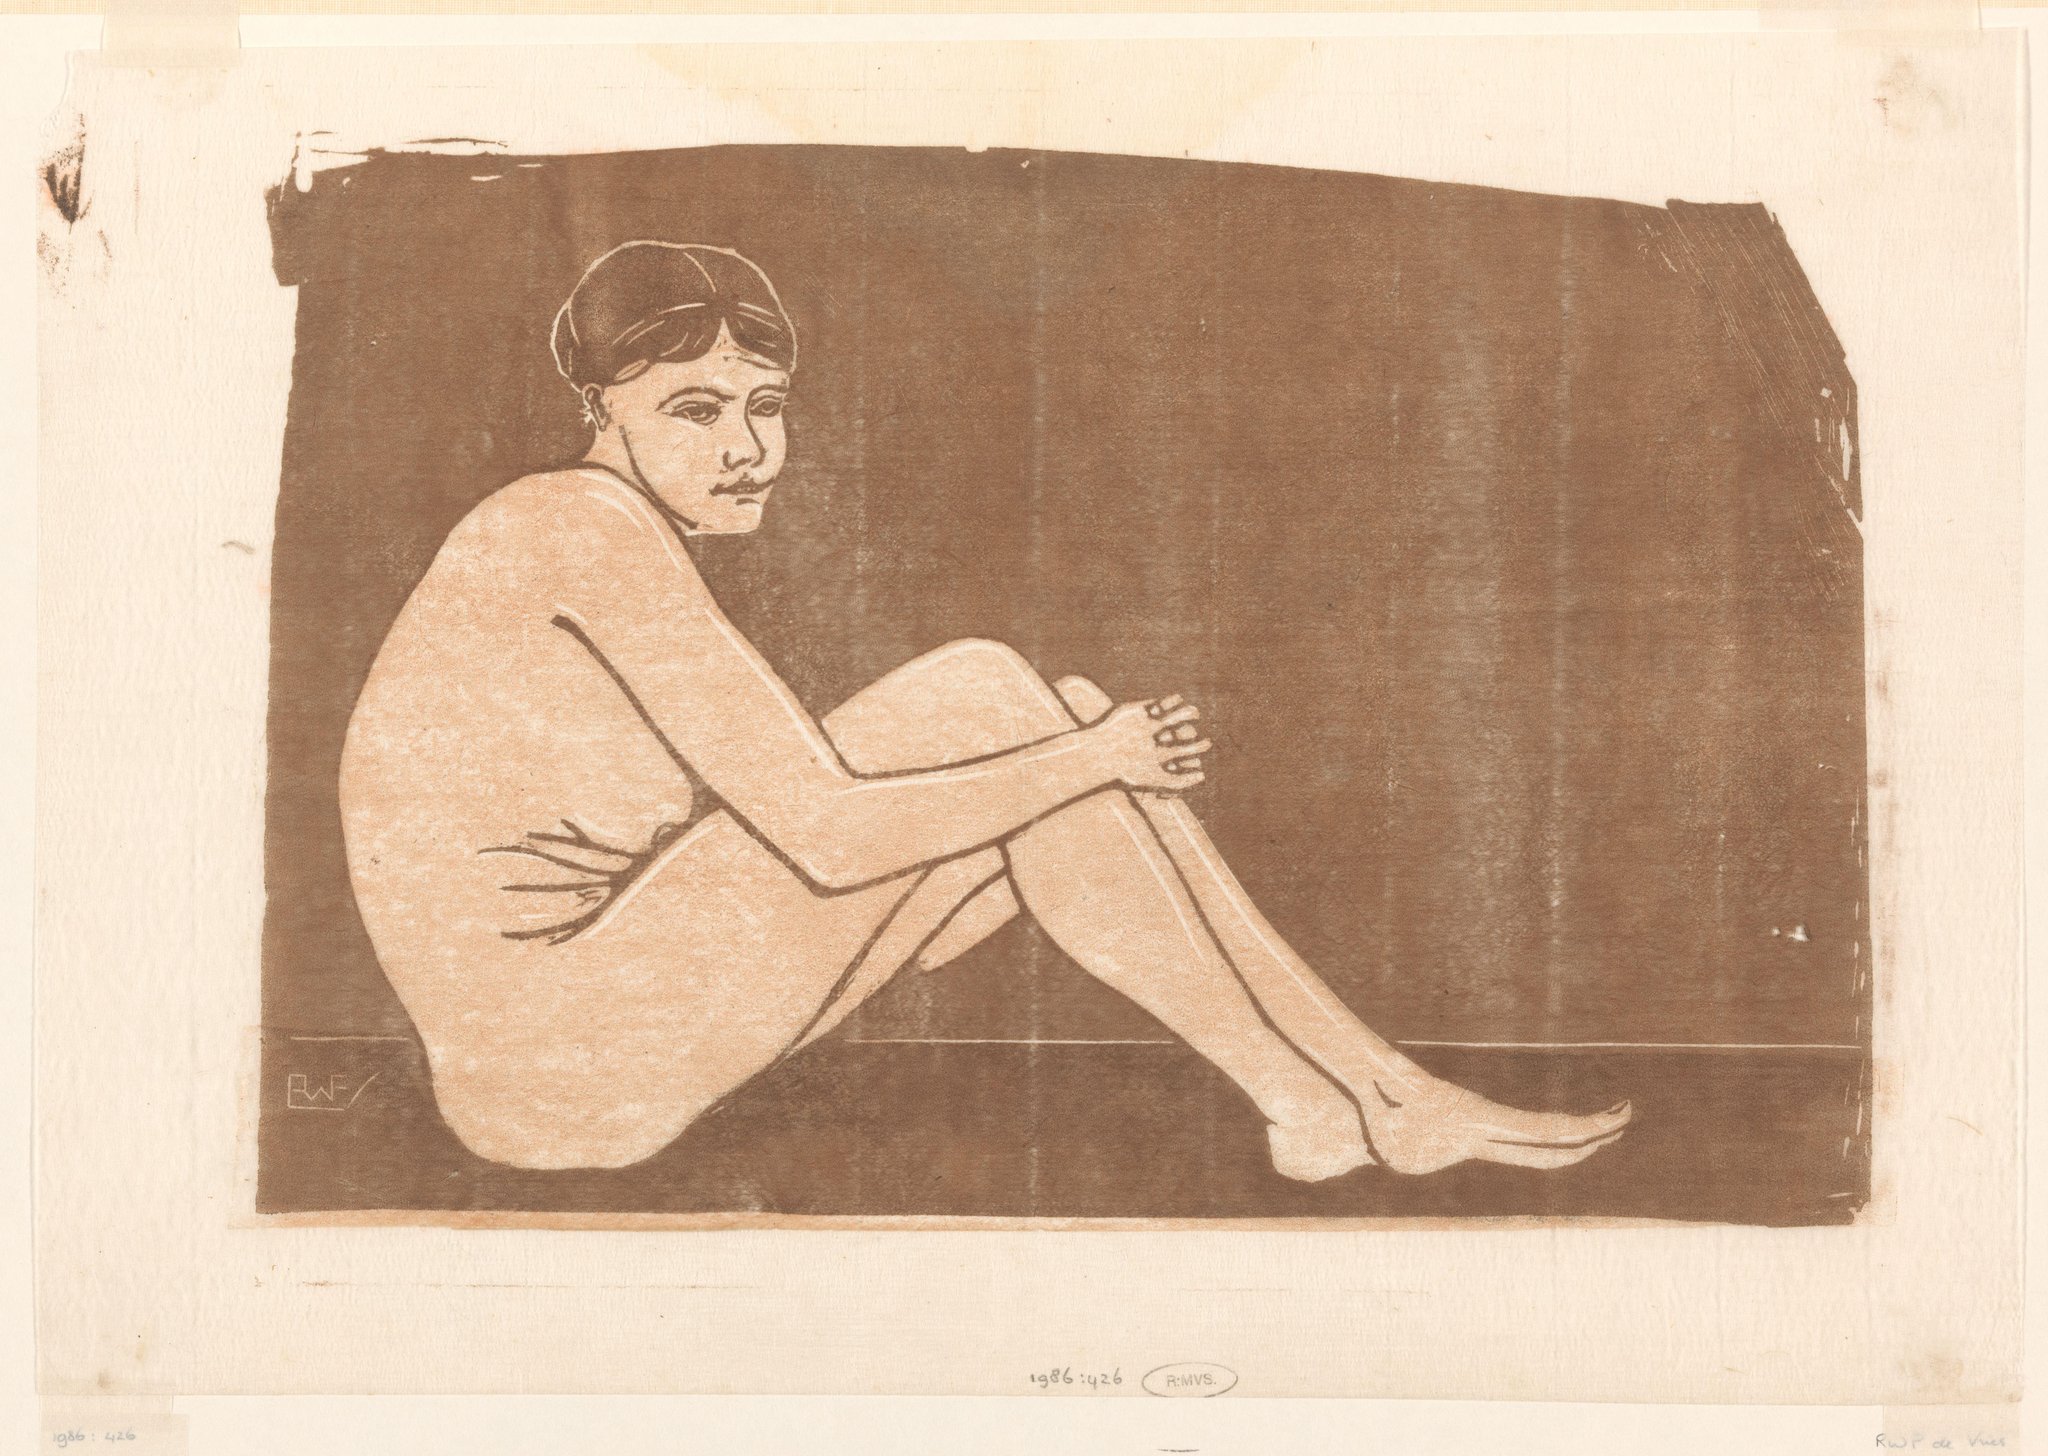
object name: print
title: Naakte zittende vrouw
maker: reinier willem petrus de vries (1874-1953)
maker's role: draughtsman, print maker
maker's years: 1874-1953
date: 1884-1952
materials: paper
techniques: linocut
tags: sitting figure - aa - female human figure, the (nude) human figure; 'corpo humano' (ripa) - aa - female human figure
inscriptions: collector's mark: Lugt 2228